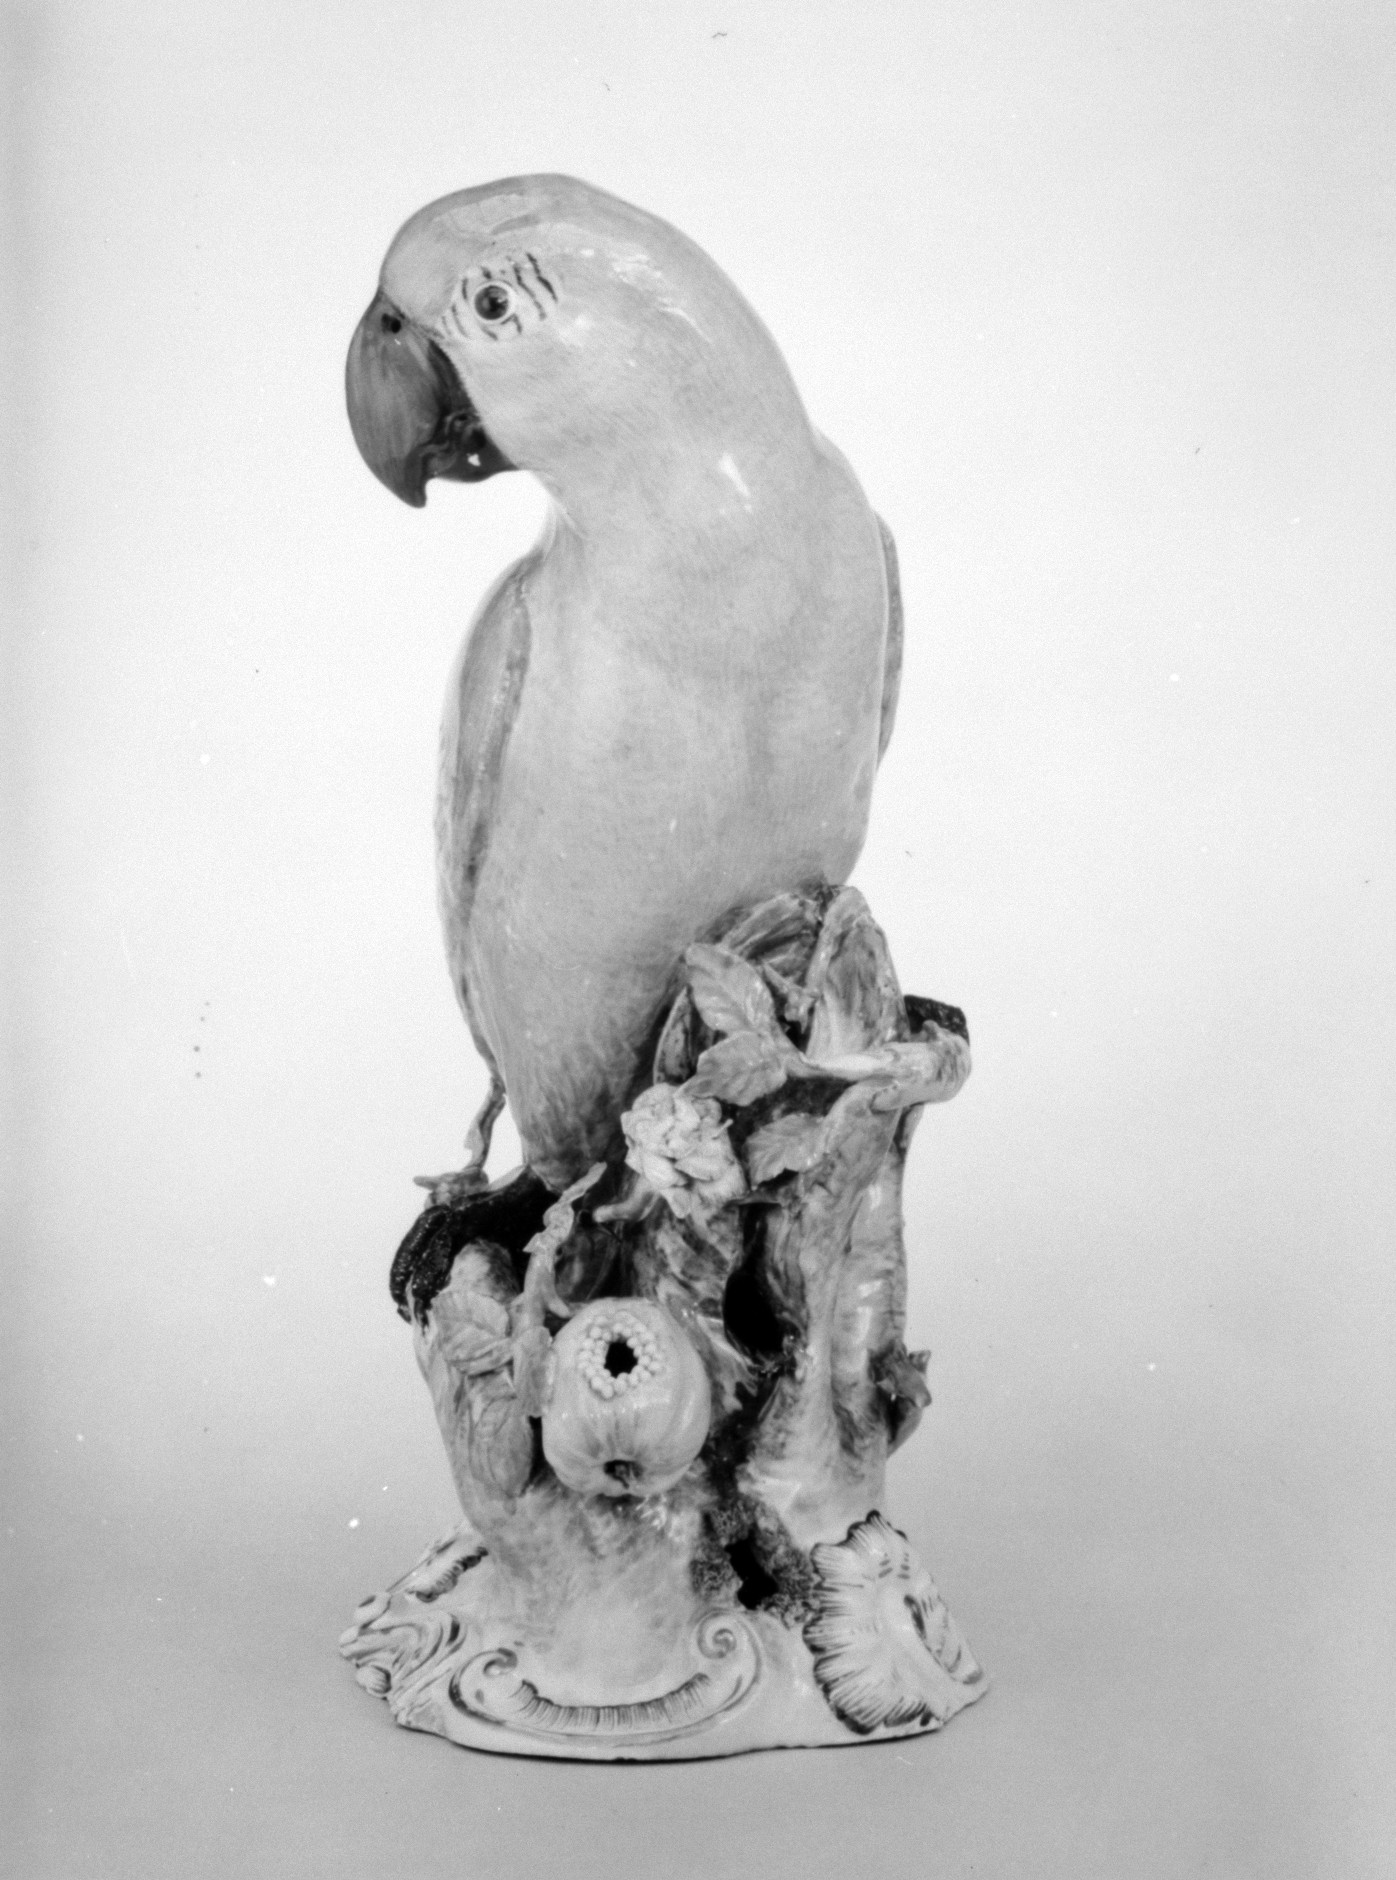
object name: figure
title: Parrot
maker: ludwigsburg porcelain manufactory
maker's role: manufactory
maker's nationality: german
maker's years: 1758-1824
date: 1765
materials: hard paste porcelain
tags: parrots